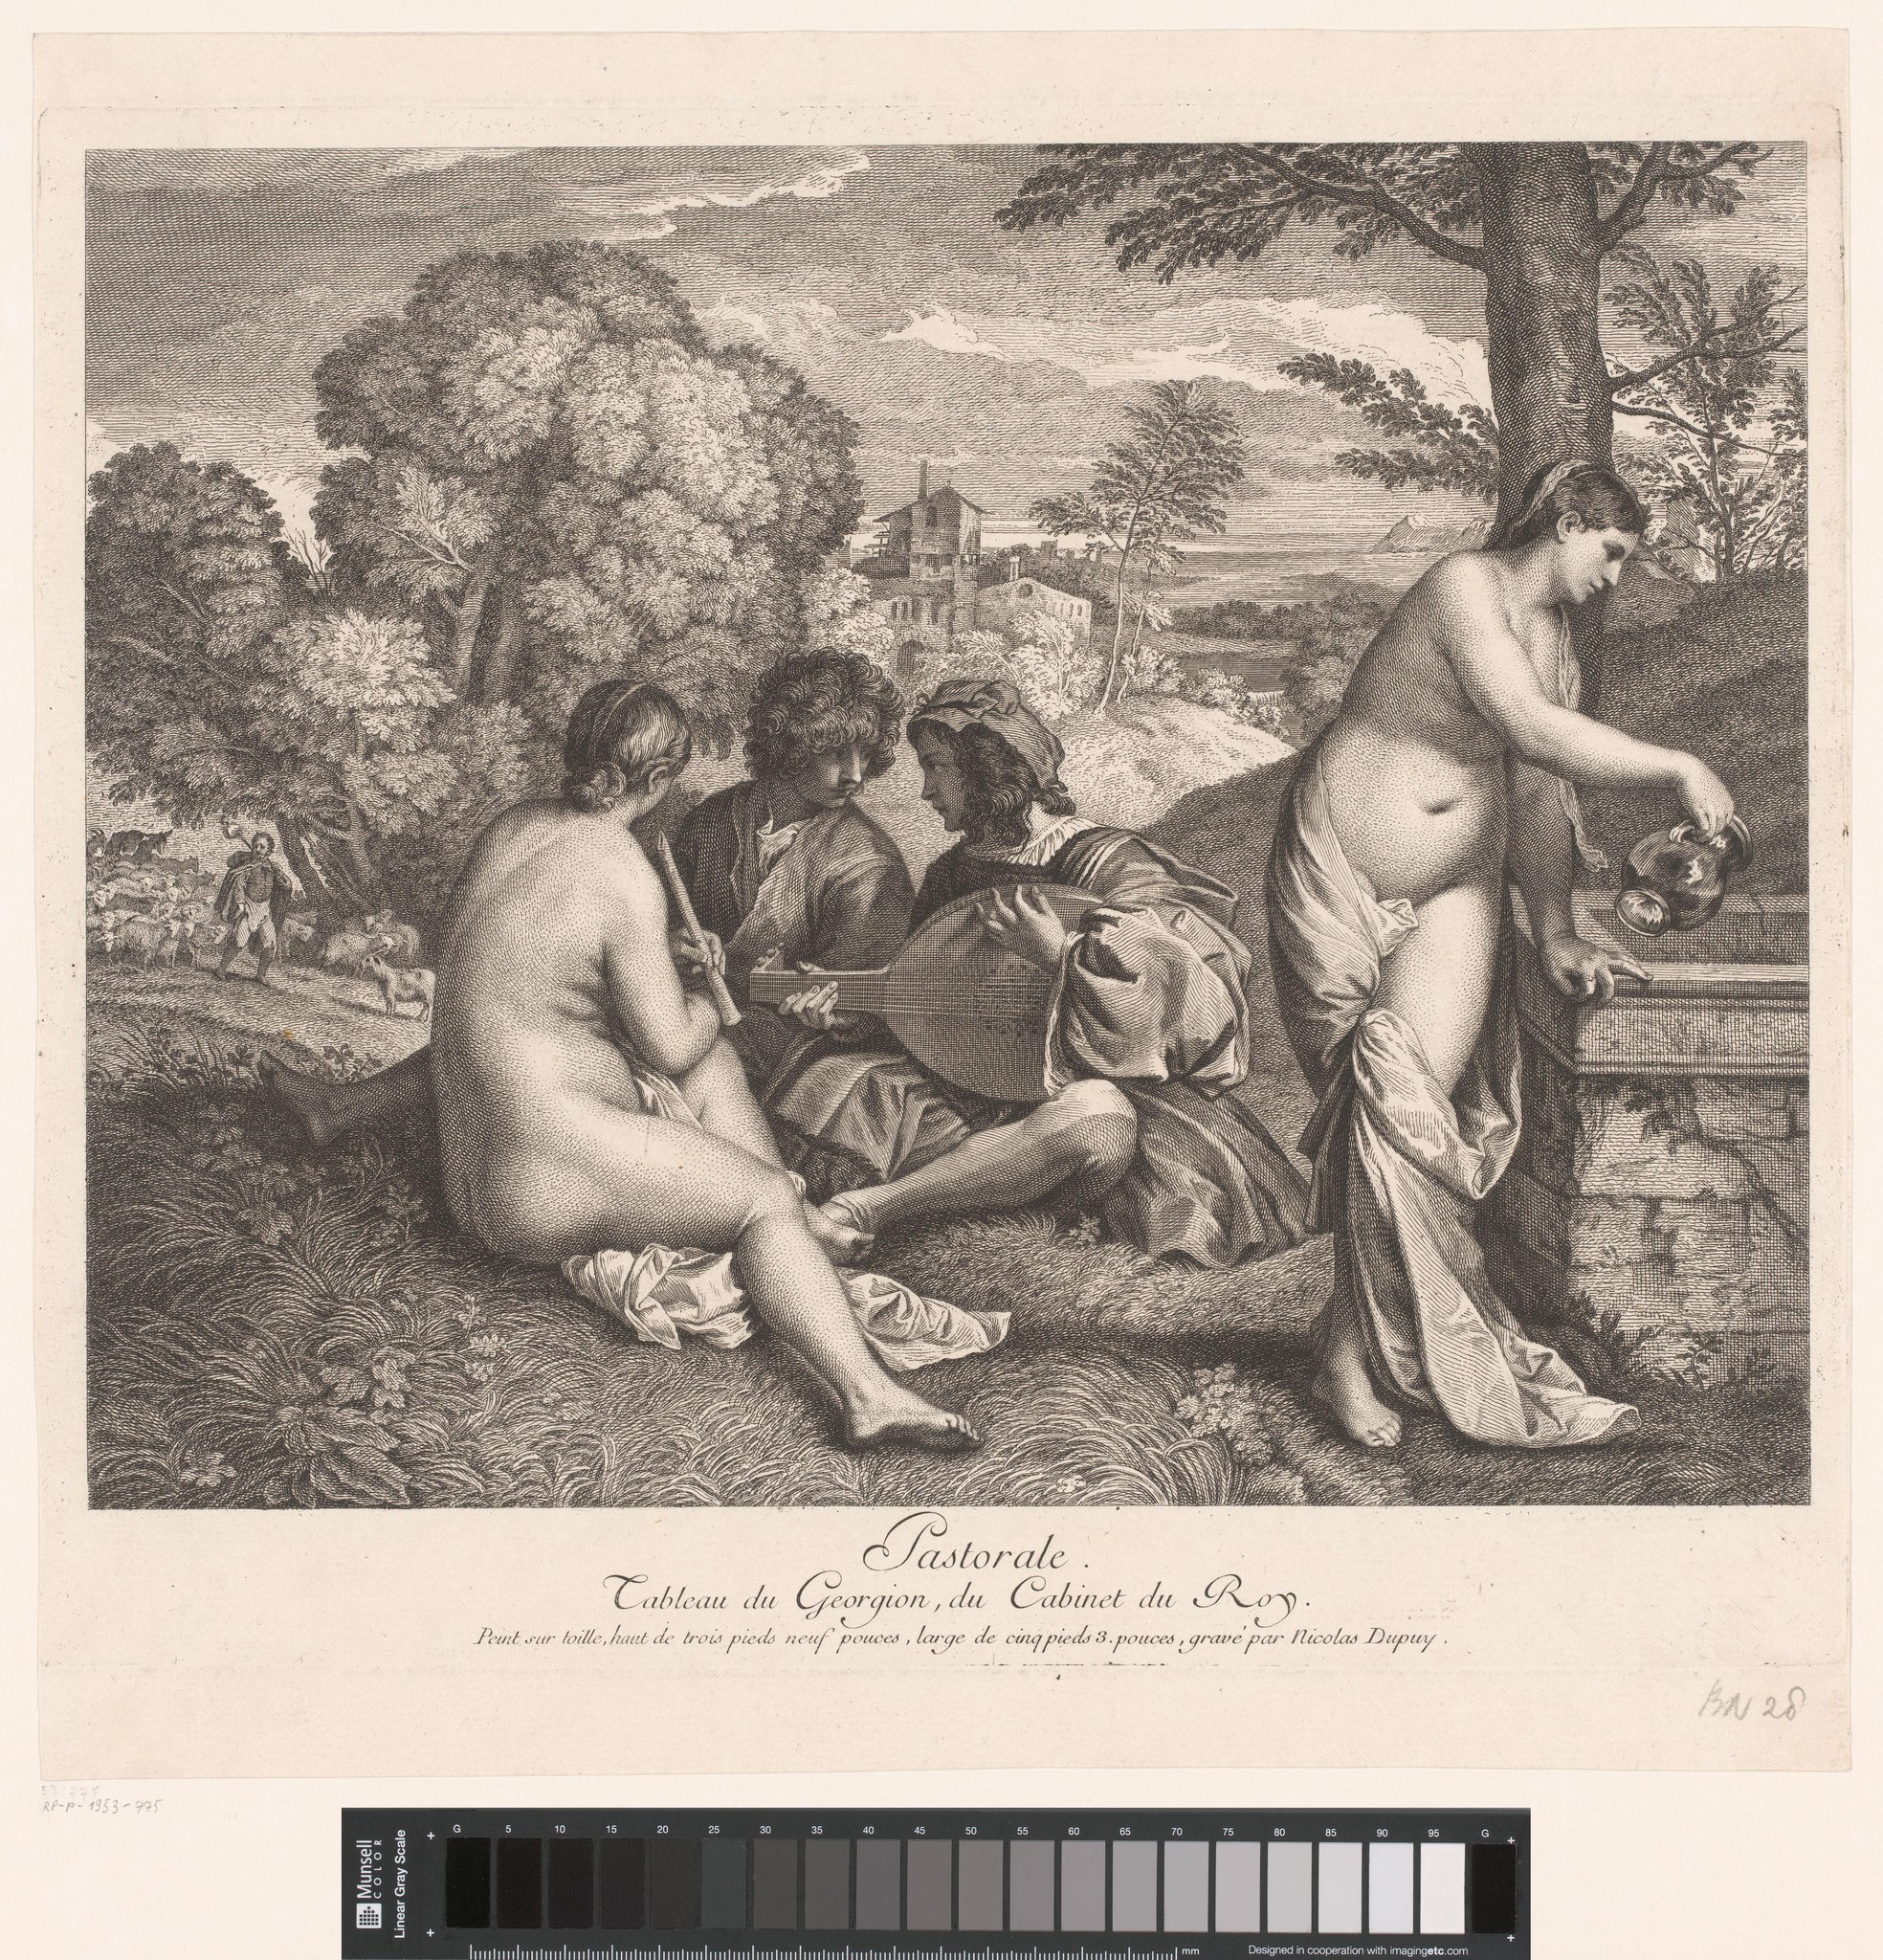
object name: print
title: Muzikanten in een landschap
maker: nicolas-gabriel dupuis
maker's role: print maker, publisher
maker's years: 1698-1771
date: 1742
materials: paper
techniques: engraving, etching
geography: france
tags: well, landscapes, musician - cc - out of doors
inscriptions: collector's mark: Lugt 2760, collector's mark: Lugt 2228